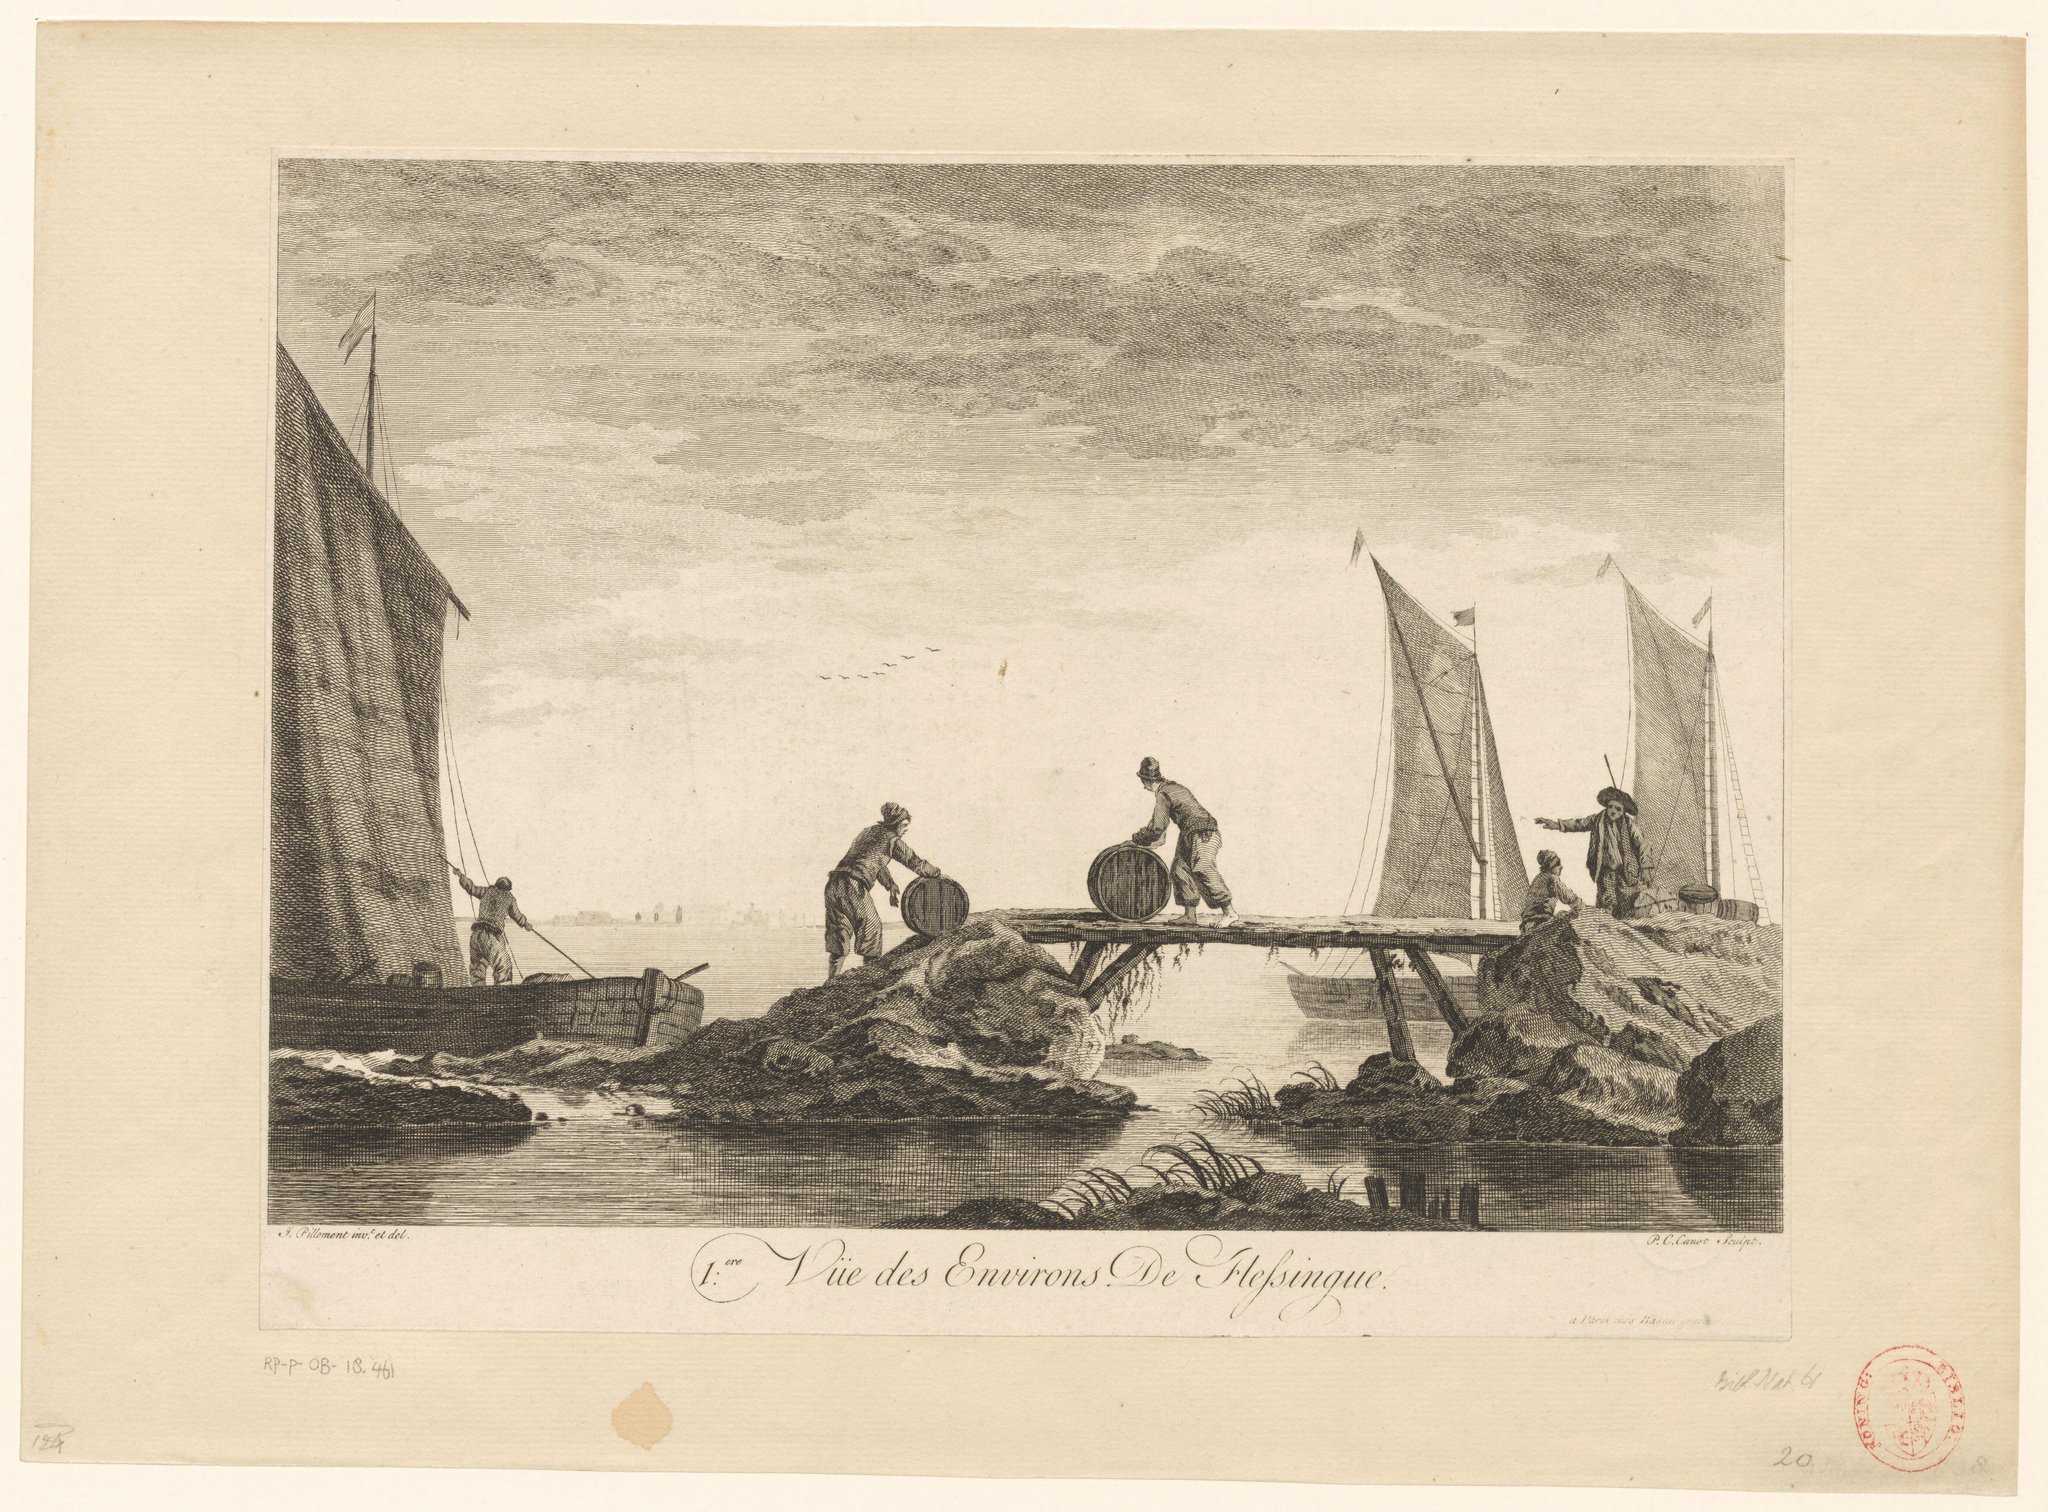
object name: print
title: Gezichten op Vlissingen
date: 1738-1761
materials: paper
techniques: engraving, etching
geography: paris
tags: harbouring (+ number of persons ~ traffic and transport), flushing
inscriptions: collector's mark: Lugt 1838, collector's mark: Lugt 240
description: Deze prent maakt deel uit van een serie van vier prenten.